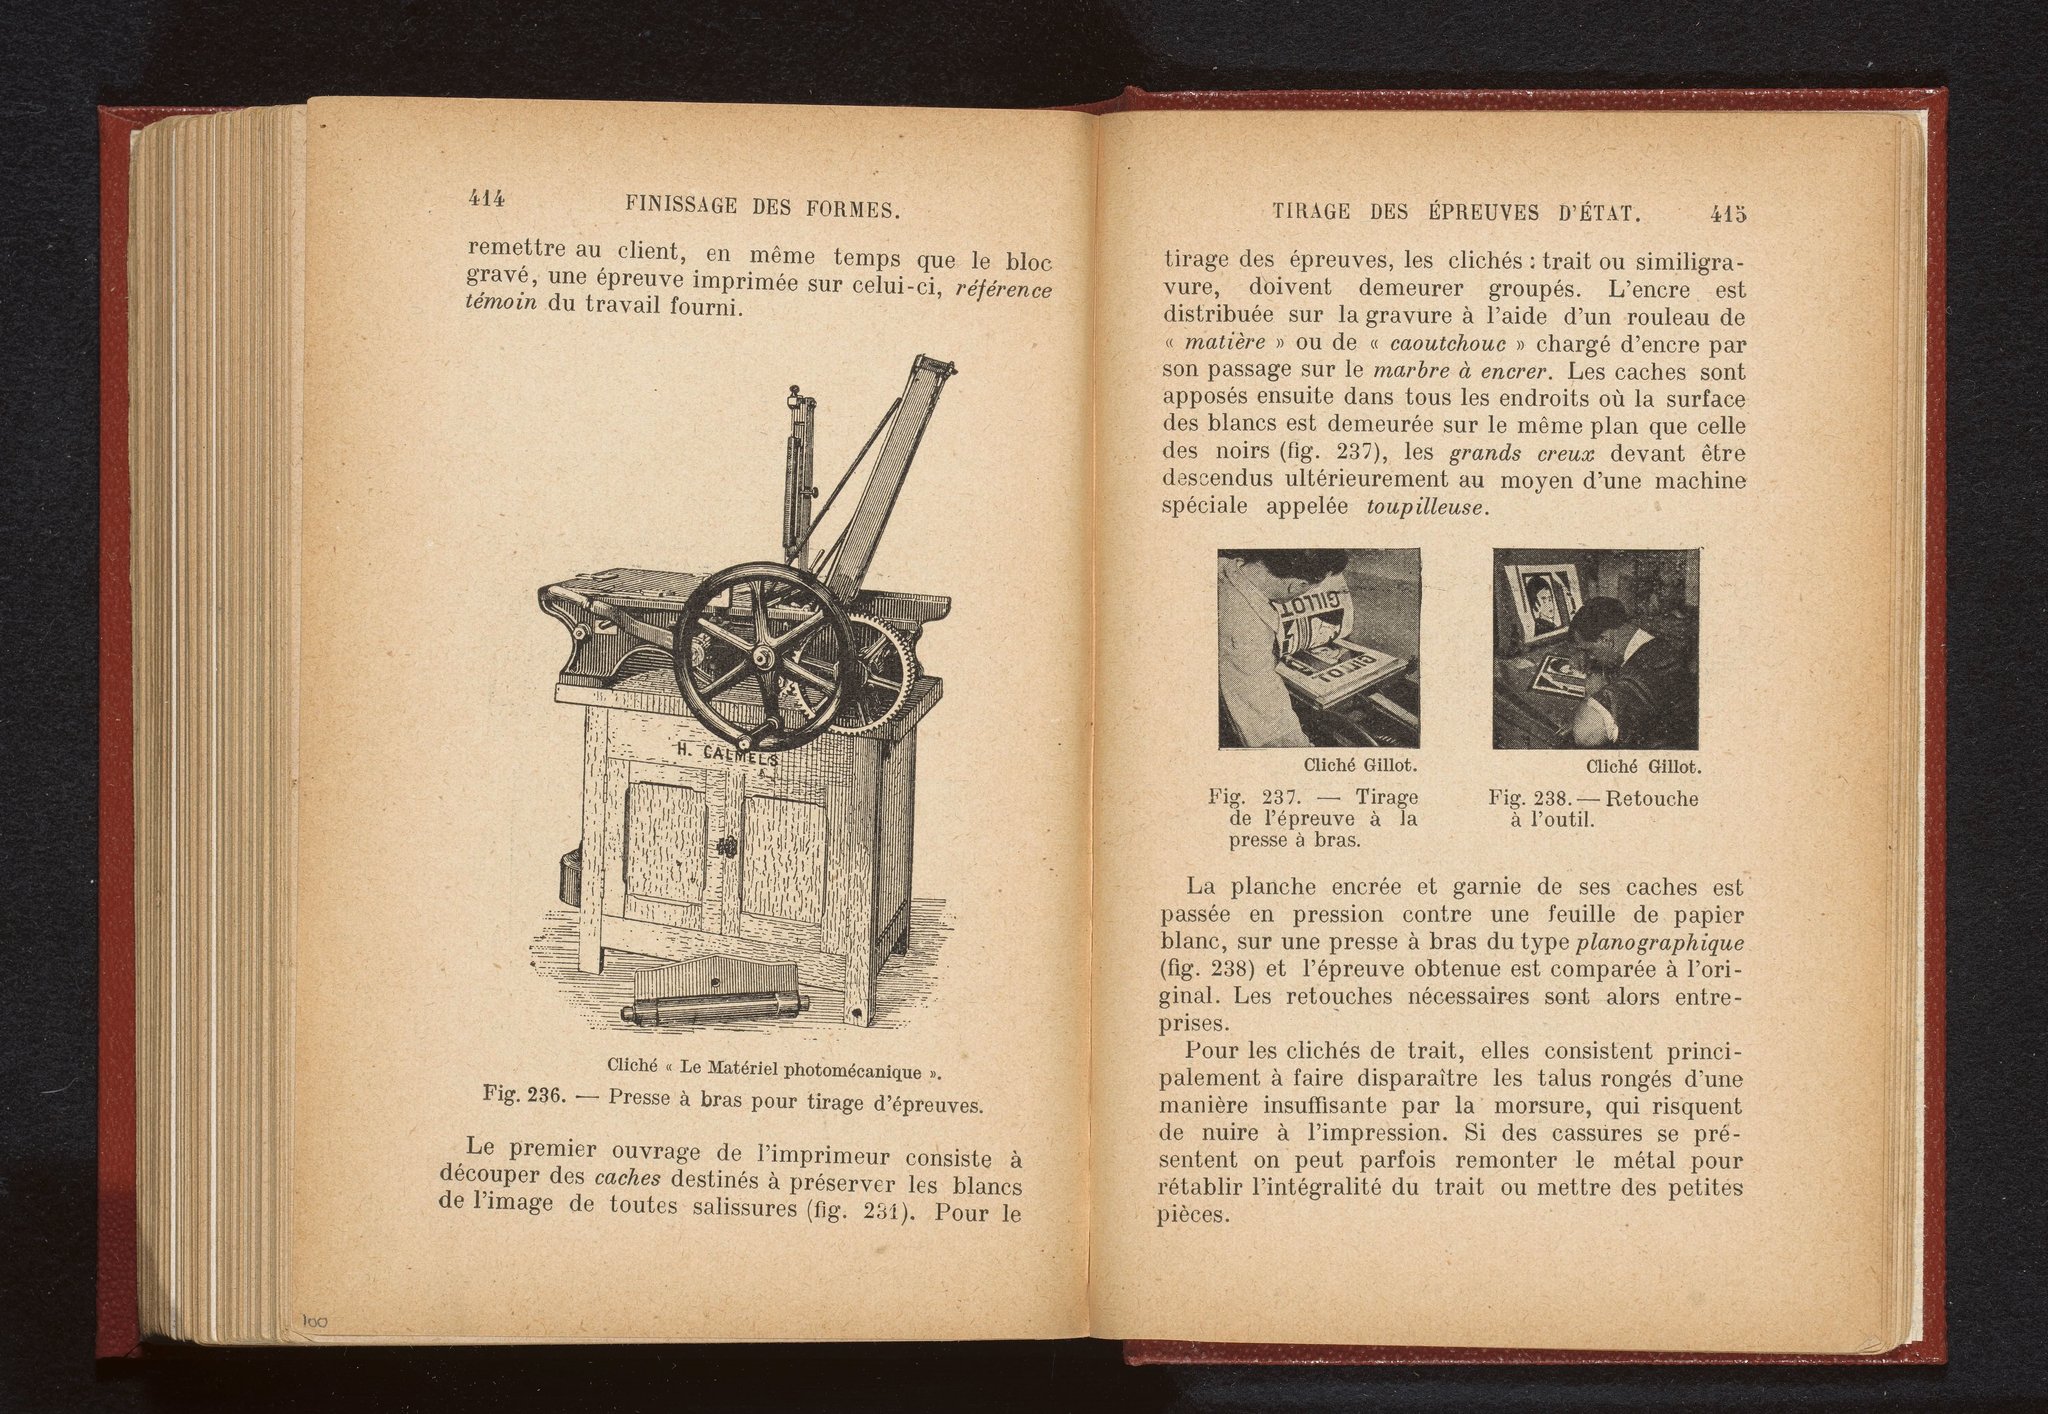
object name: photomechanical print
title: Man die een fotomechanische afdruk maakt en retoucheert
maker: Anonymous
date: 1922-1932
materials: paper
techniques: autotype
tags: print, e.g.: engraving, etching, lithograph, photographic apparatus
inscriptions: number: ‘Fig. 237. Fig. 238.’